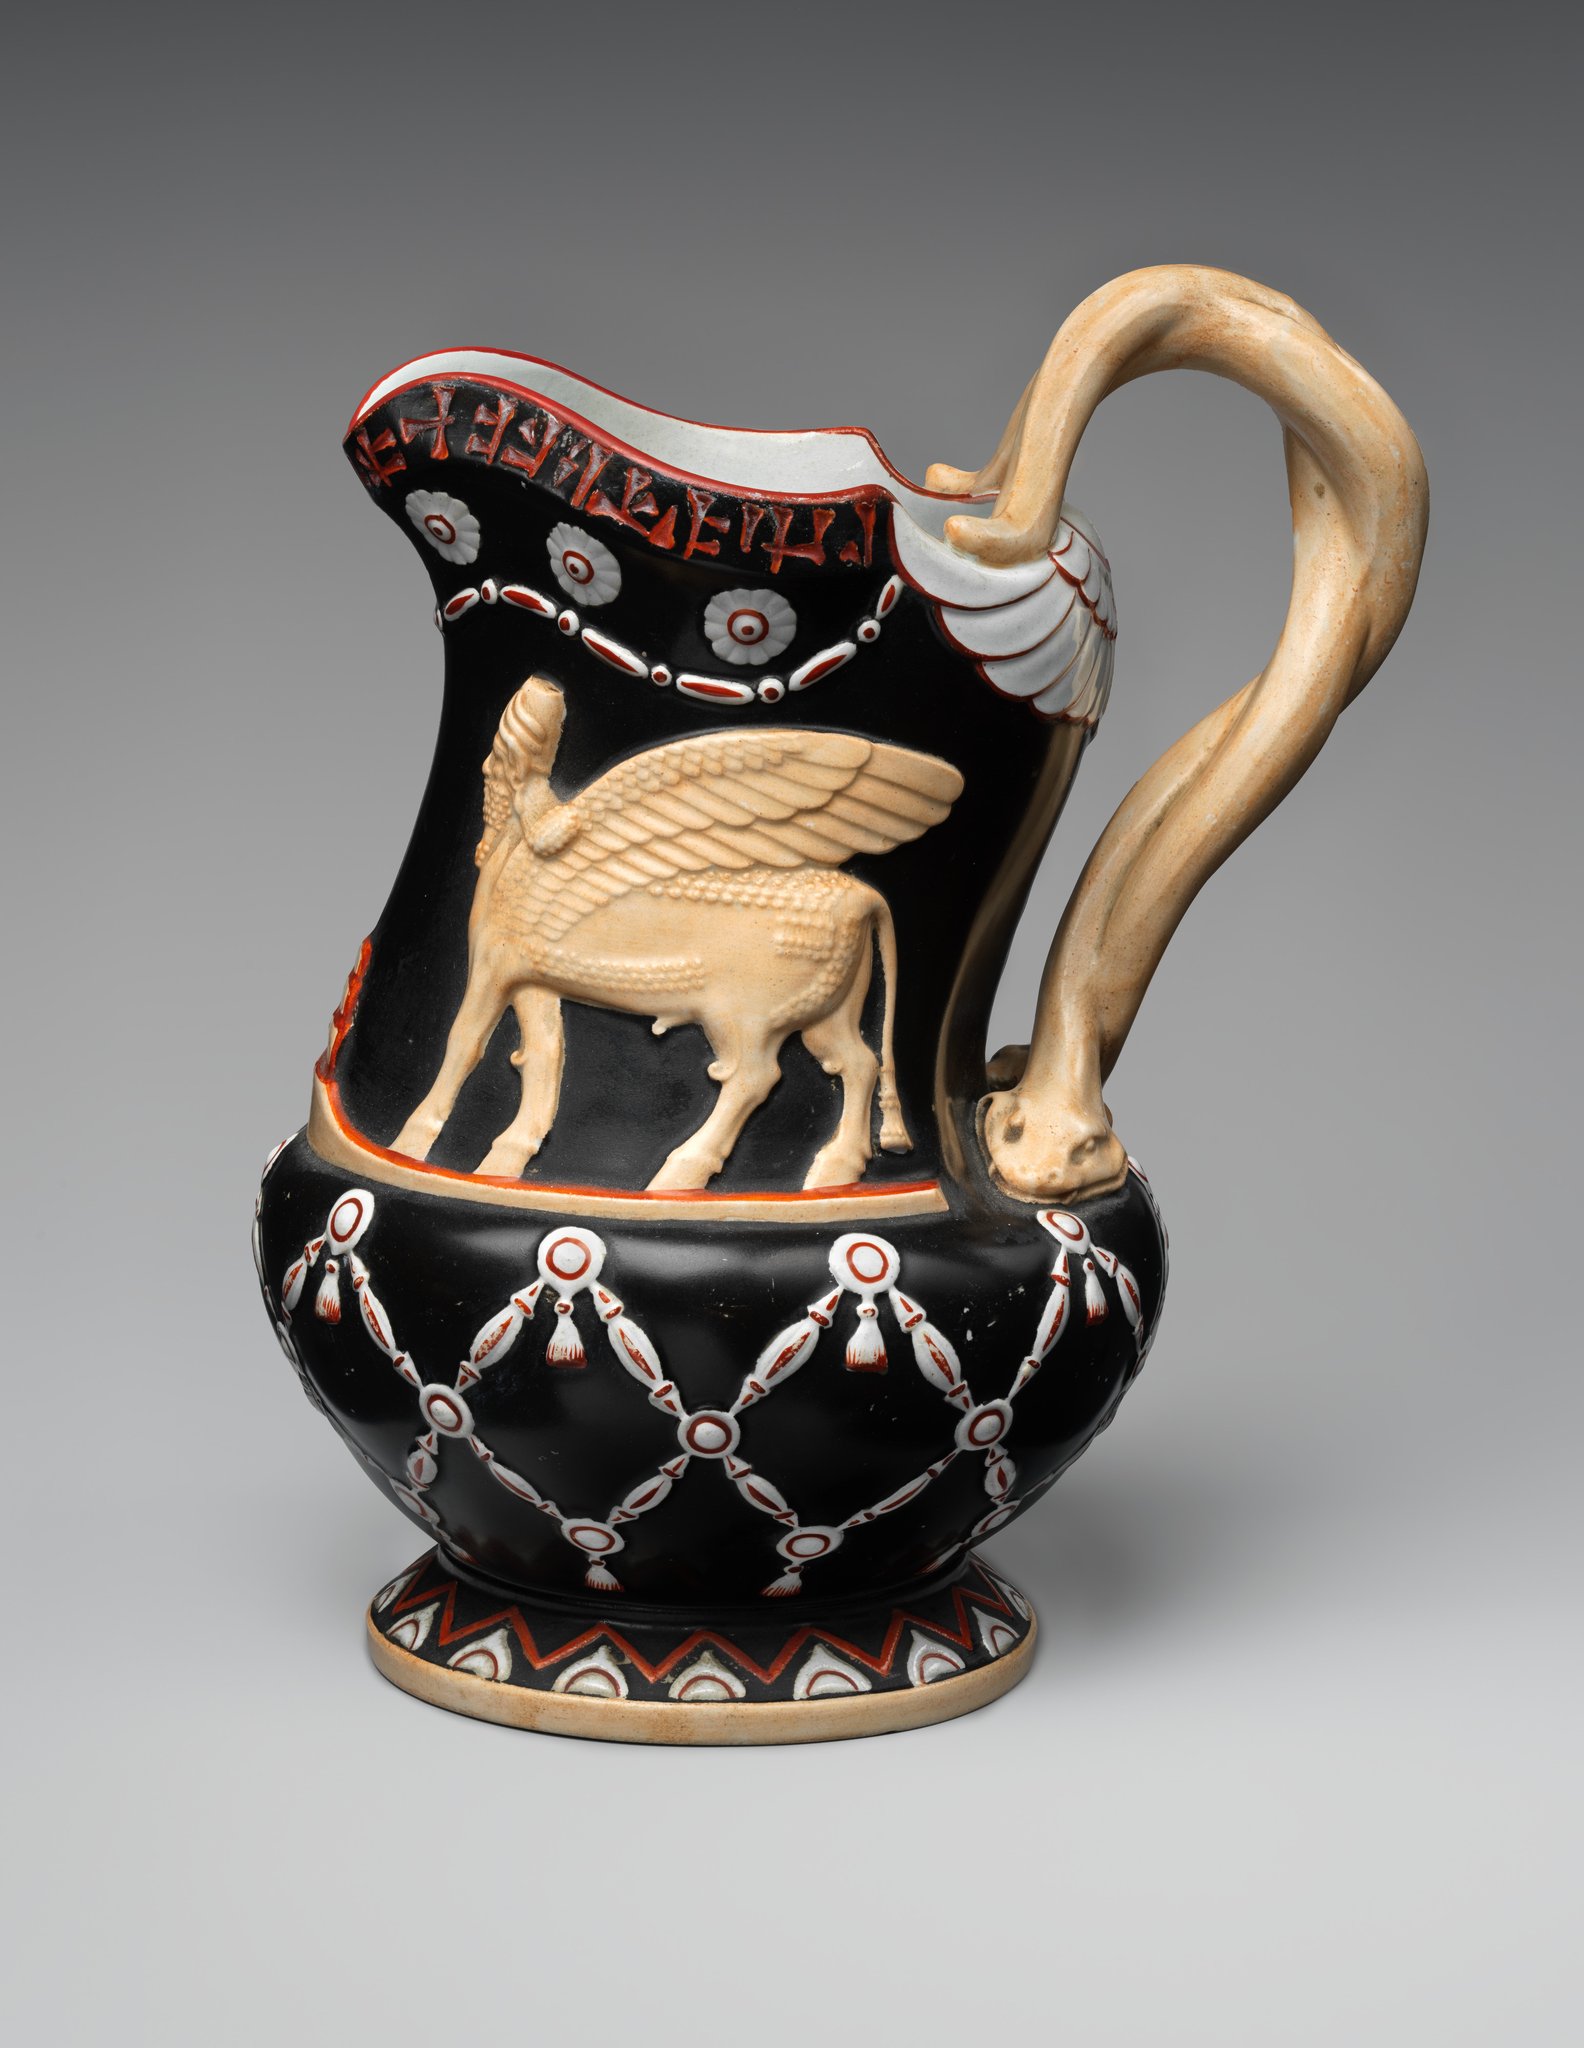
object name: jug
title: Jug with Assyrian-inspired decoration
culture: british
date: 1851-1860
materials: stoneware